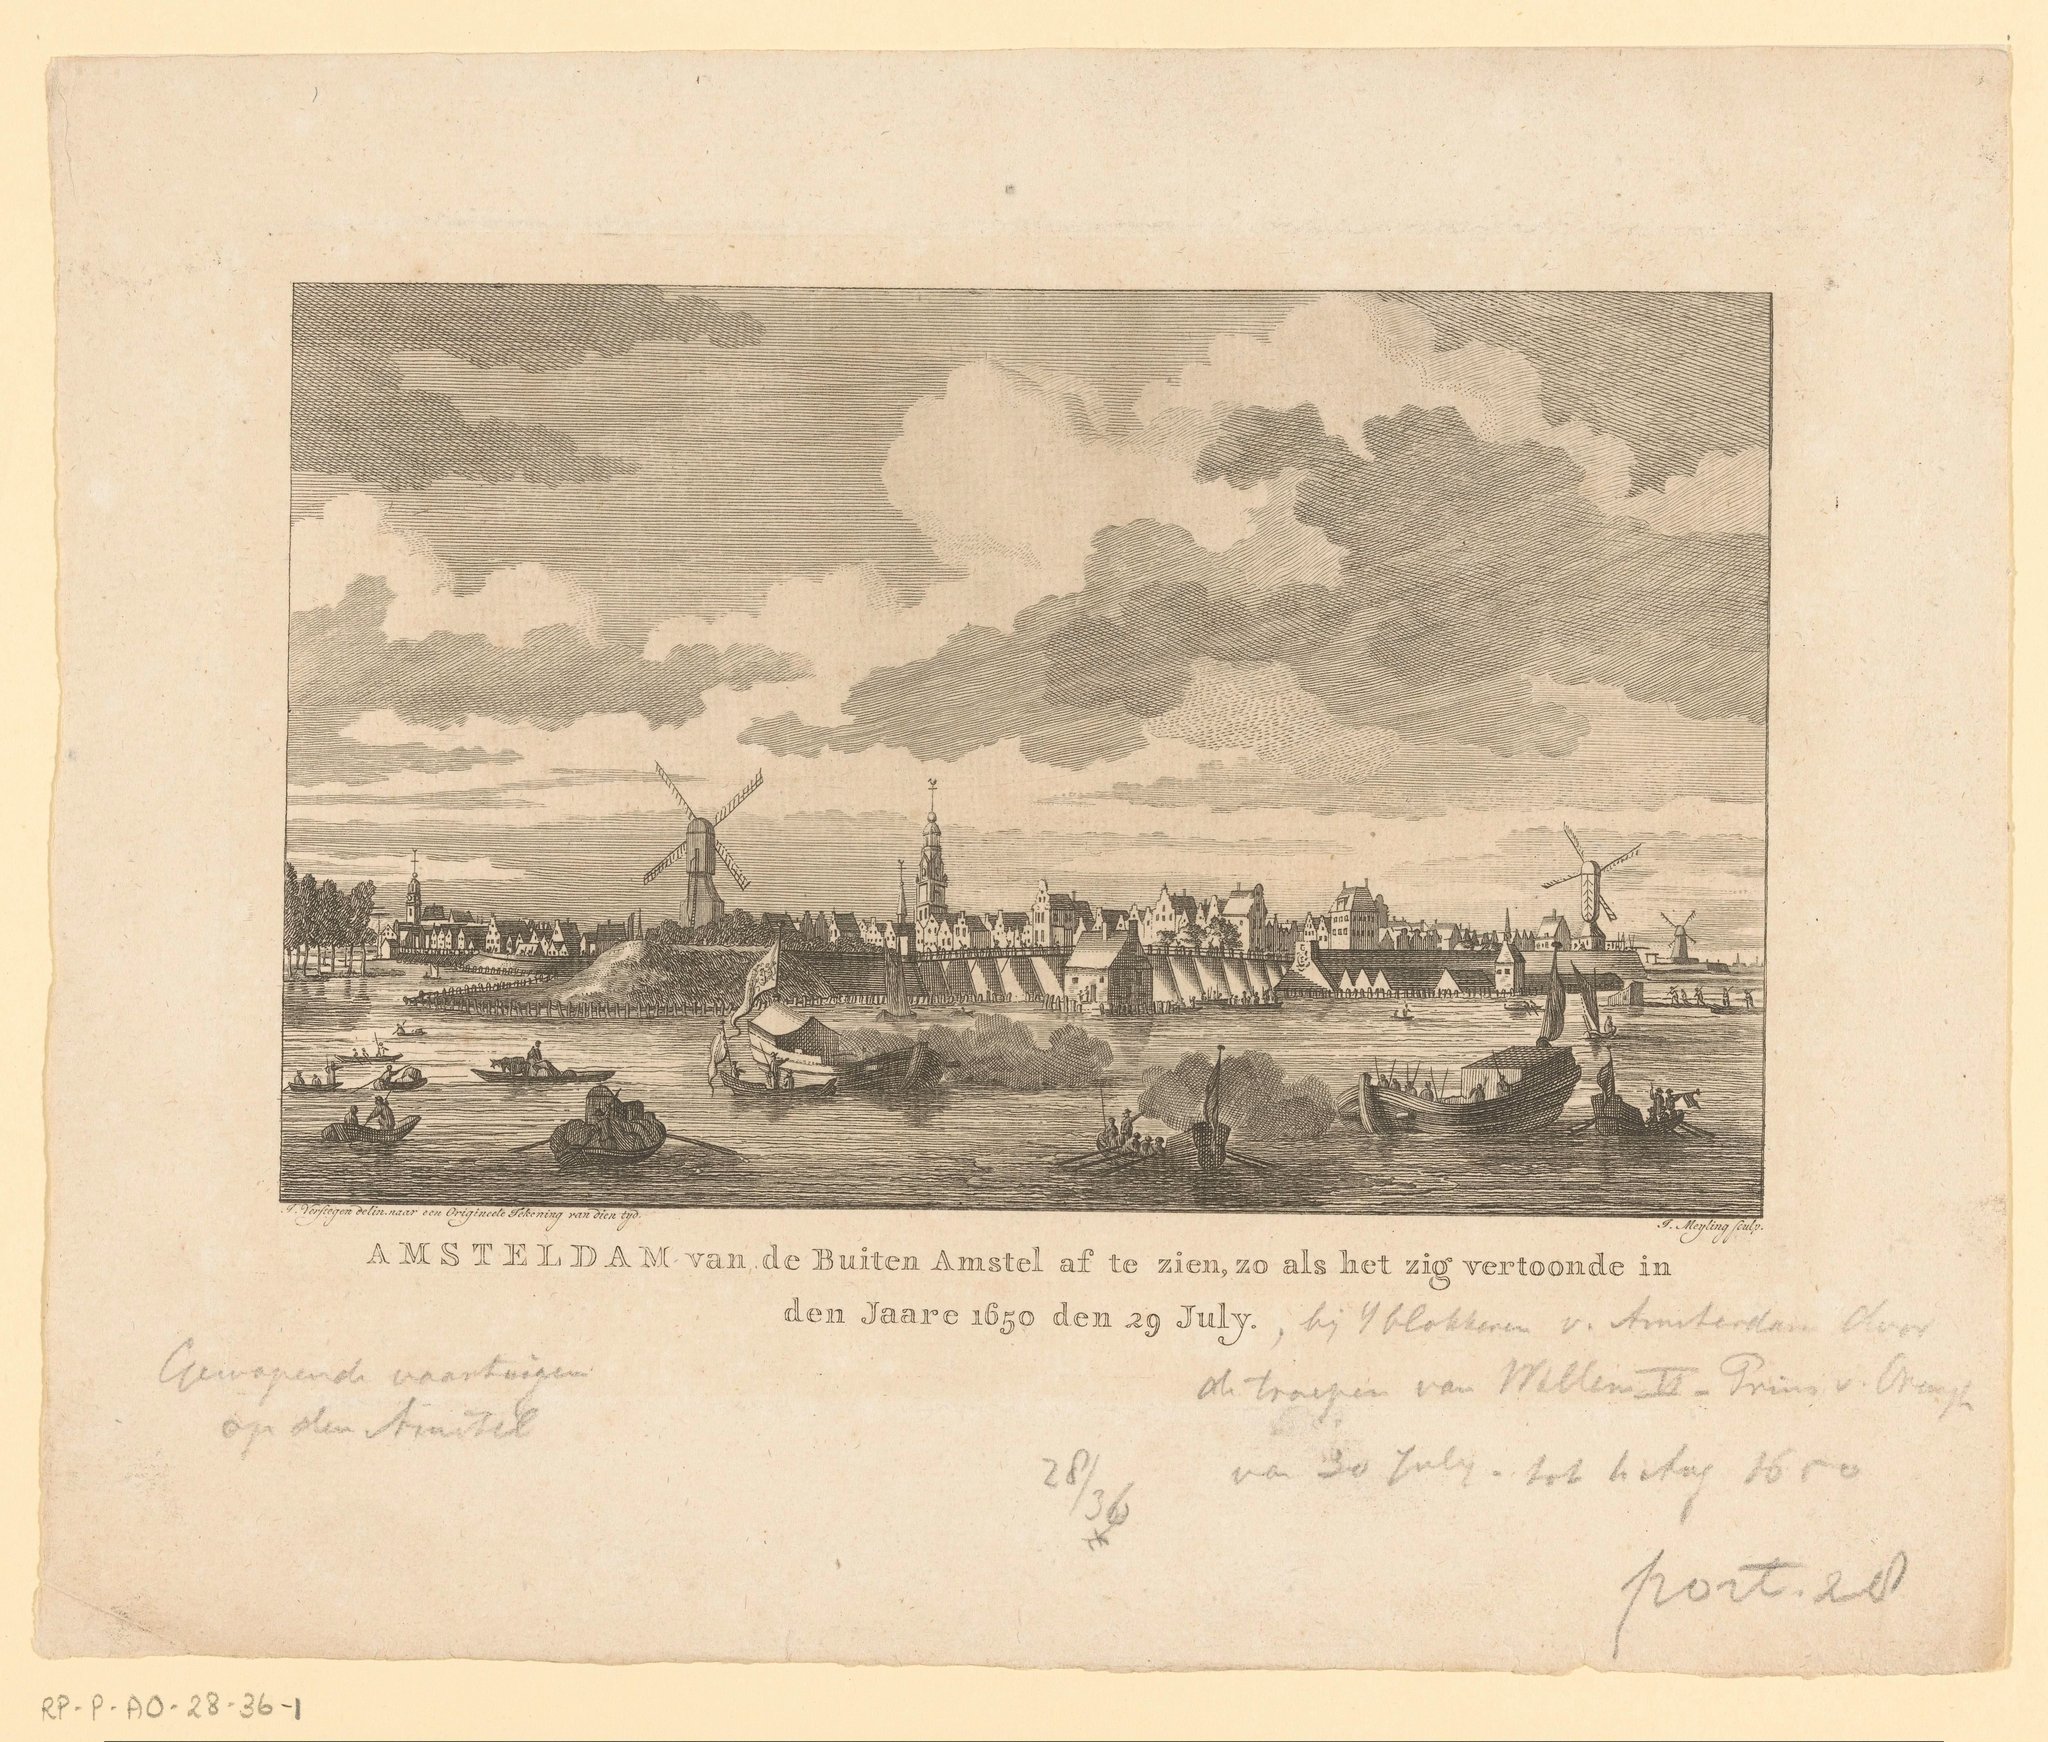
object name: print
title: Amsteldam van de Buiten Amstel af te zien, zo als het zig vertoonde in den jaare 1650 den 29 july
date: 1750-1800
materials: paper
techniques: engraving, etching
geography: amsterdam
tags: william ii (prince of orange), rowing-boat, canoe, etc., city-walls, prospect of city, town panorama, silhouette of city, amsterdam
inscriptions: collector's mark: Lugt 2228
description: Gezicht op Amsterdam, gezien vanaf de Buiten-Amstel, zonder de Blokhuizen, 29 juli 1650 (rond de Aanslag op Amsterdam). Met verschillende bootjes (met soldaten of schutters?) op het water. Op de achtergrond de Blauwbrug en de toren van de Zuiderkerk.